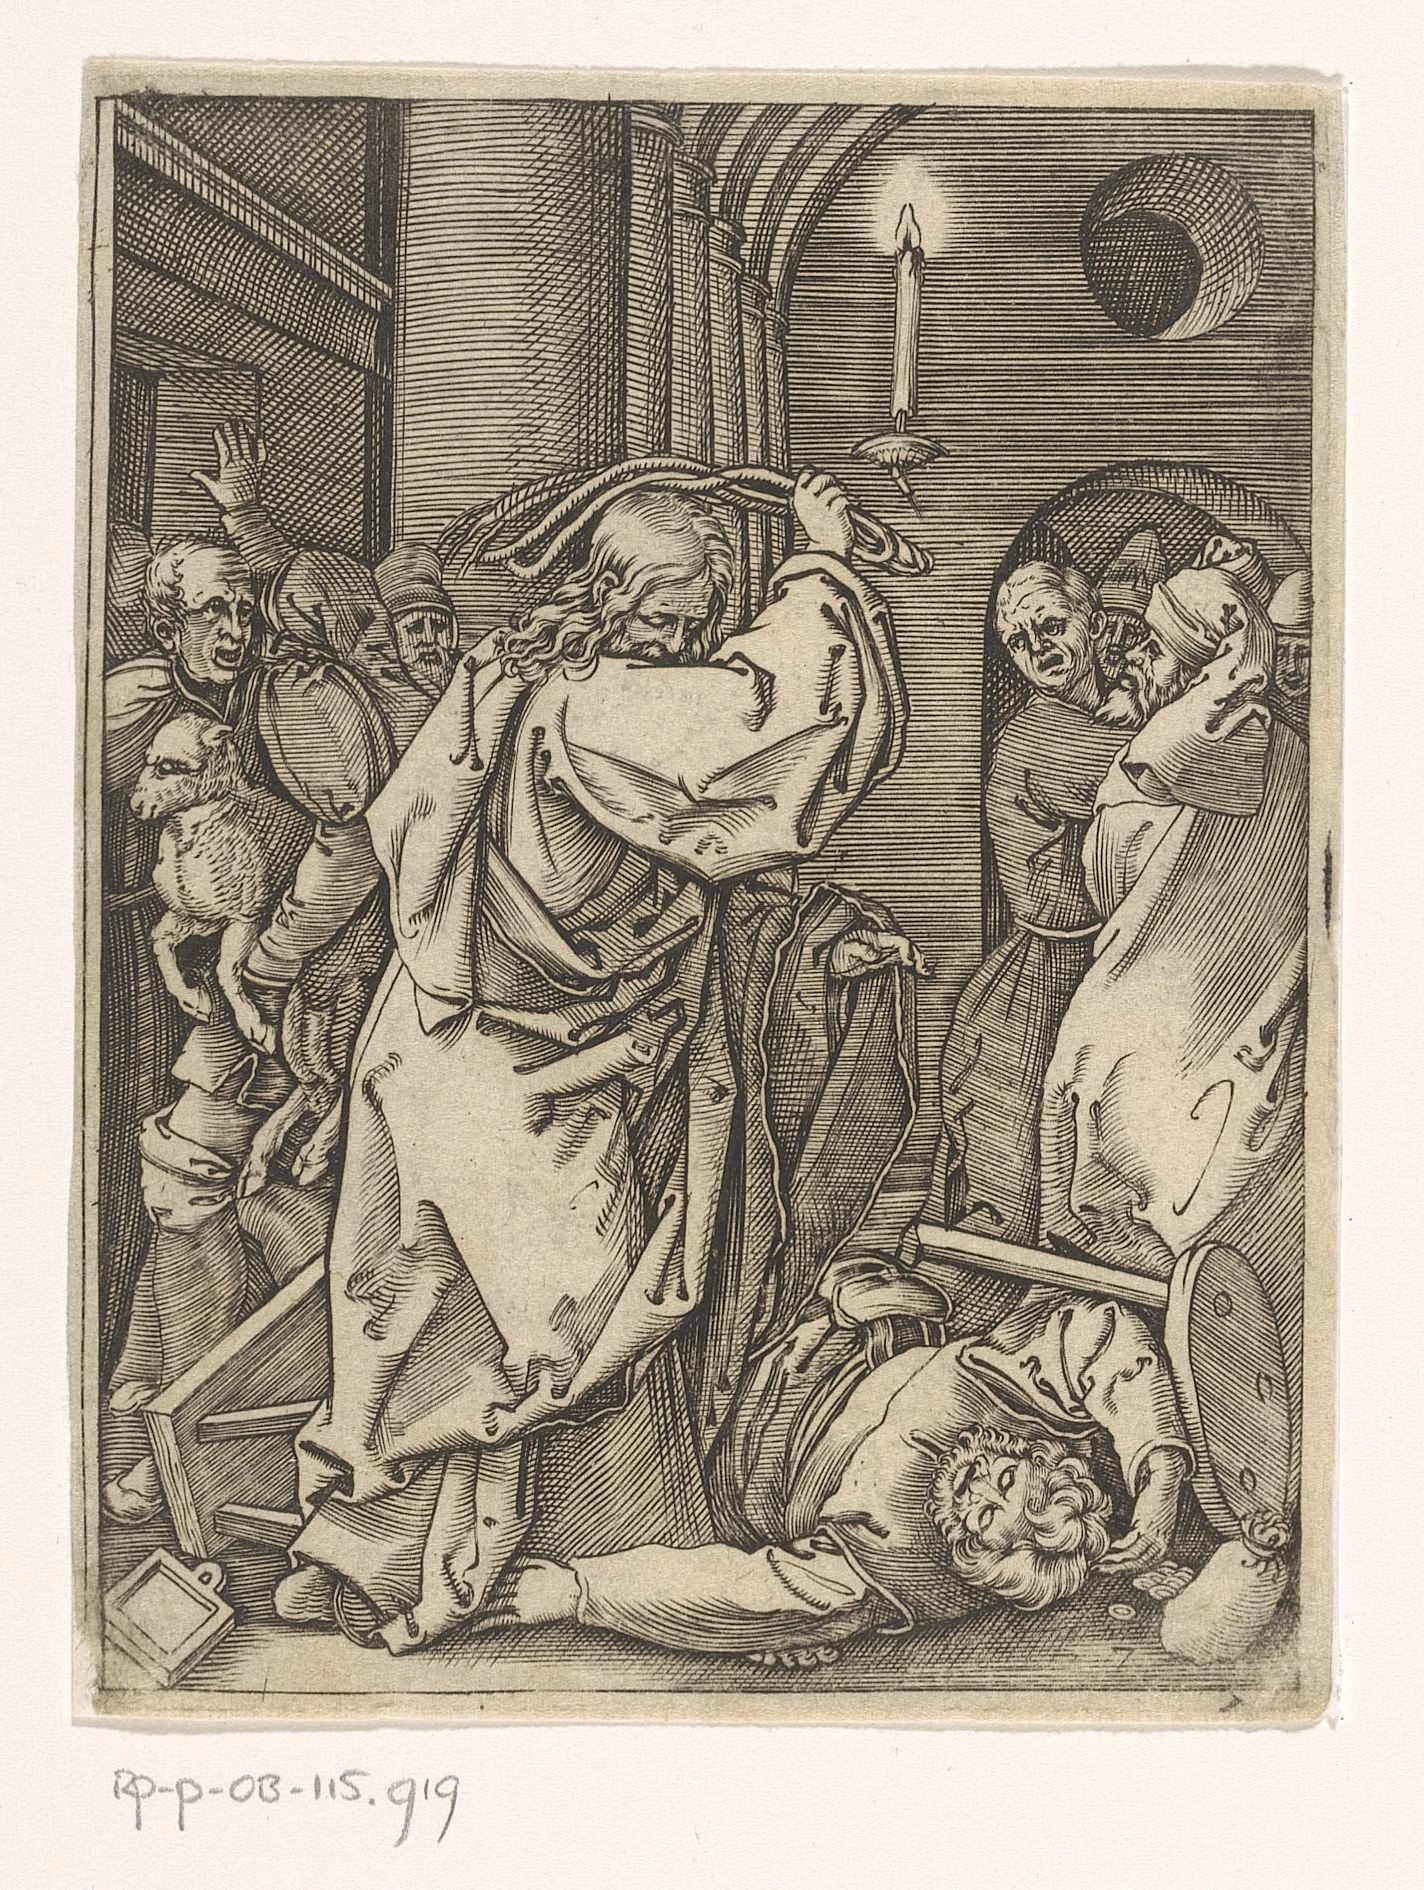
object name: print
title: Passie van Christus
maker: marcantonio raimondi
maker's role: print maker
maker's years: 1470-1534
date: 1511-1534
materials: paper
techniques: engraving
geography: italy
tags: purification of the temple ('first' and 'second'): christ driving the money-changers from the temple with a whip (matthew 21:12-13; mark 11:15-17; luke 19:45-46; john 12:12-19)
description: Prent naar houtsnede van Albrecht Dürer uit een serie van zevenendertig prenten met als onderwerp het levensverhaal van Christus, bekend als Passie van Christus.